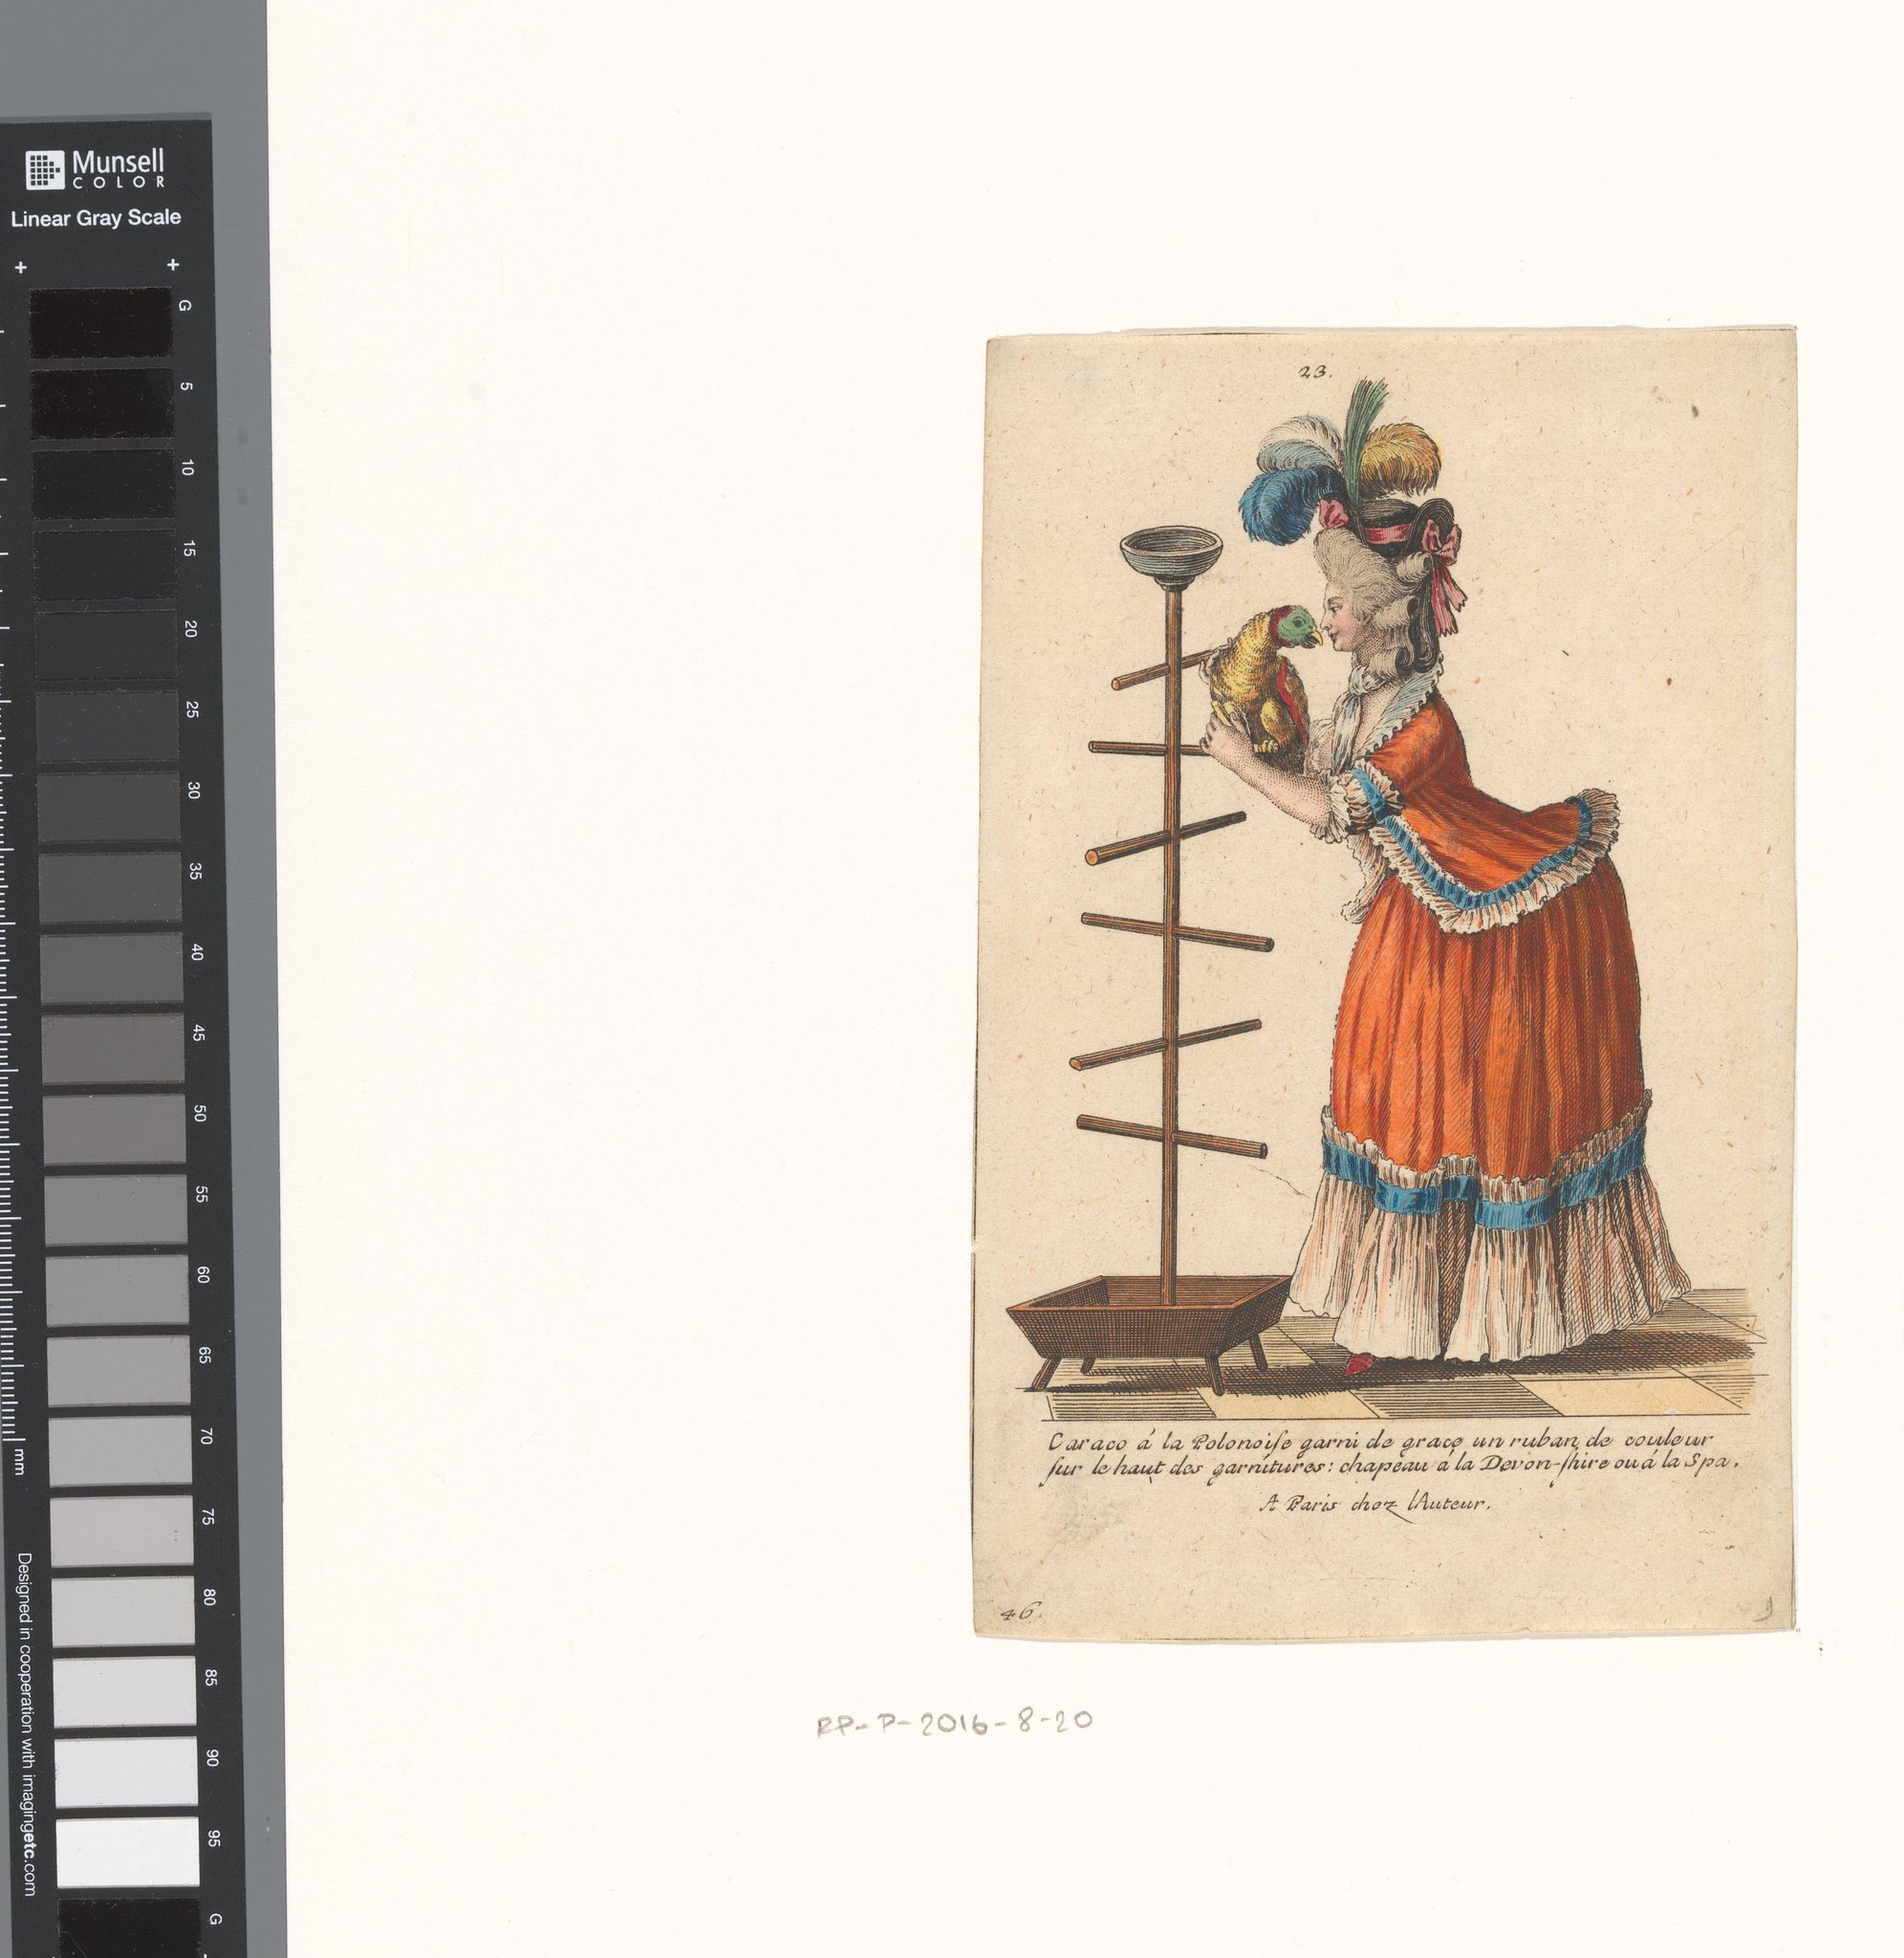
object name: fashion print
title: Gallerie des Modes et Costumes Français, nr. 23, kopie naar dd. 165: Caraco à la Polonois (...)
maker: Anonymous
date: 1780-1785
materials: paper, ink, watercolor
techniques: etching, hand coloring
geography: paris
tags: clothing for the upper part of the body (caraco) (+ women's clothes), neck-gear ~ clothing (neckerchief) (+ women's clothes), fasteners for clothes (+ women's clothes), ornamental birds: parrot, fashion plates, head-gear: hat (+ women's clothes), shoes, sandals (+ women's clothes), skirt (+ women's clothes), head-gear: hat (+ feathers used for clothes), dress, gown: robe à la polonaise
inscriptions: address: ‘A Paris chez l'Auteur’, collector's mark: Lugt 2228, number: ‘23’, caption (possibly false): ‘Caraco à la Polonoise, garni de gracq un ruban de couleur sur le haut des garnitures: chapeau à la Devon-shire ou à la Spa’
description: Jonge vrouw, staand bij papegaai op een standaard. Ze is gekleed in een rode caraco à la Polonaise, afgezet met een geplooide rand van gaas. Rode rok met aan de onderrand een breede gerimpelde strook. Hoofdtooi met opstaande veren, die 'chapeau à la Devonshire' wordt genoemd. Verkleinde kopie naar dd.165 uit serie dd. 28e Cahier des Costumes Francais, 22e Suite d'Habillemens à la Mode en 1780, Gallerie des Modes et Costumes Français,